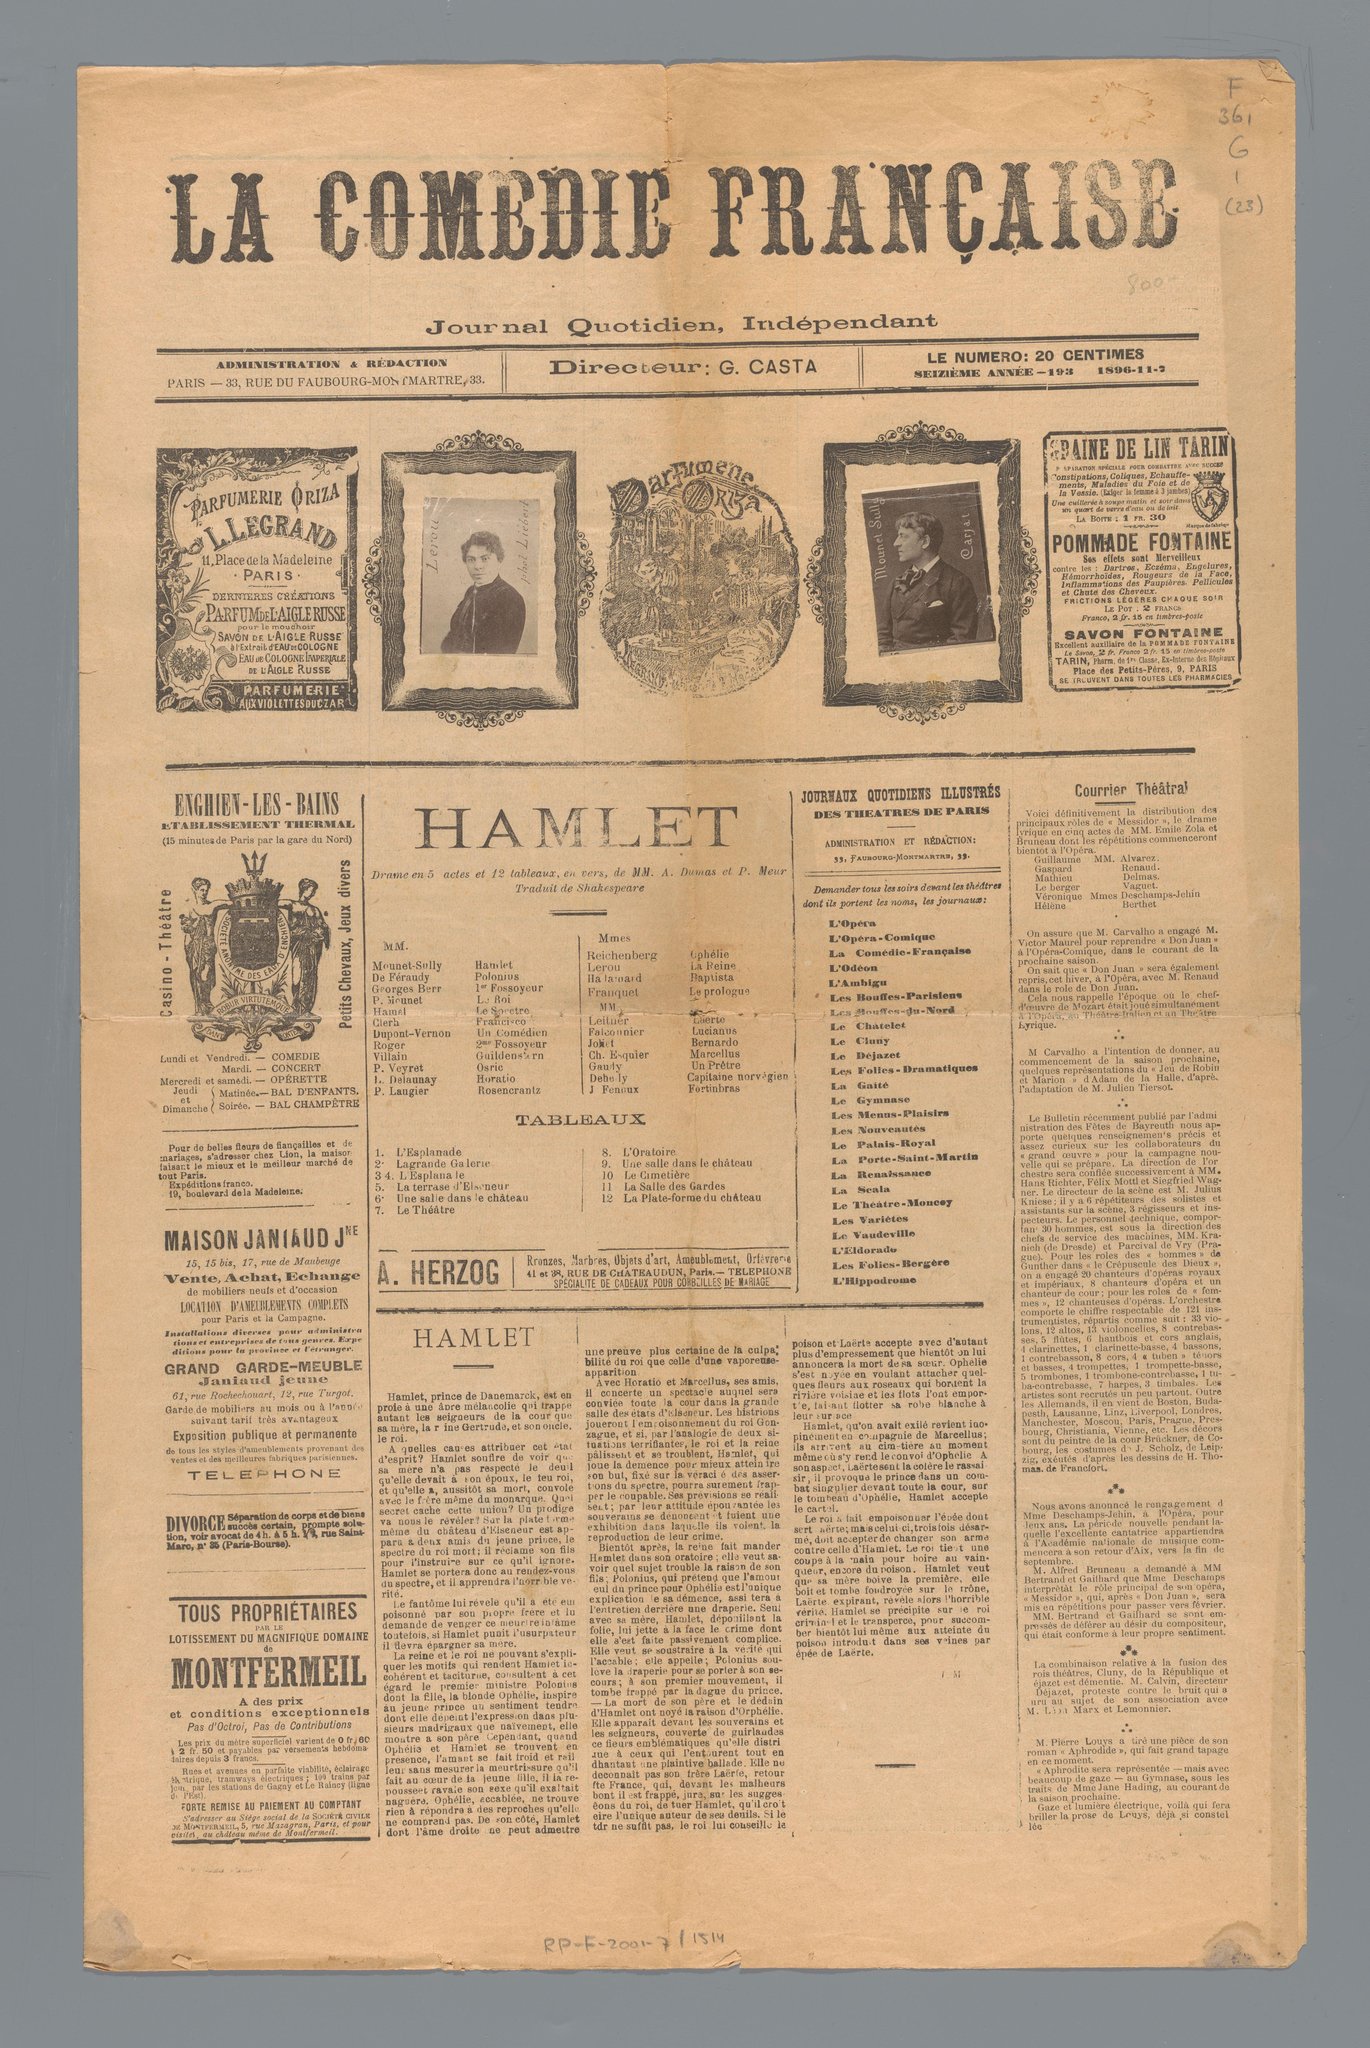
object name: photomechanical print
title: Portret van een acteur uit de Comedie Française, genaamd Lerou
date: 1891-1896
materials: paper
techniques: photograph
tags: historical persons, portrait of actor, actress